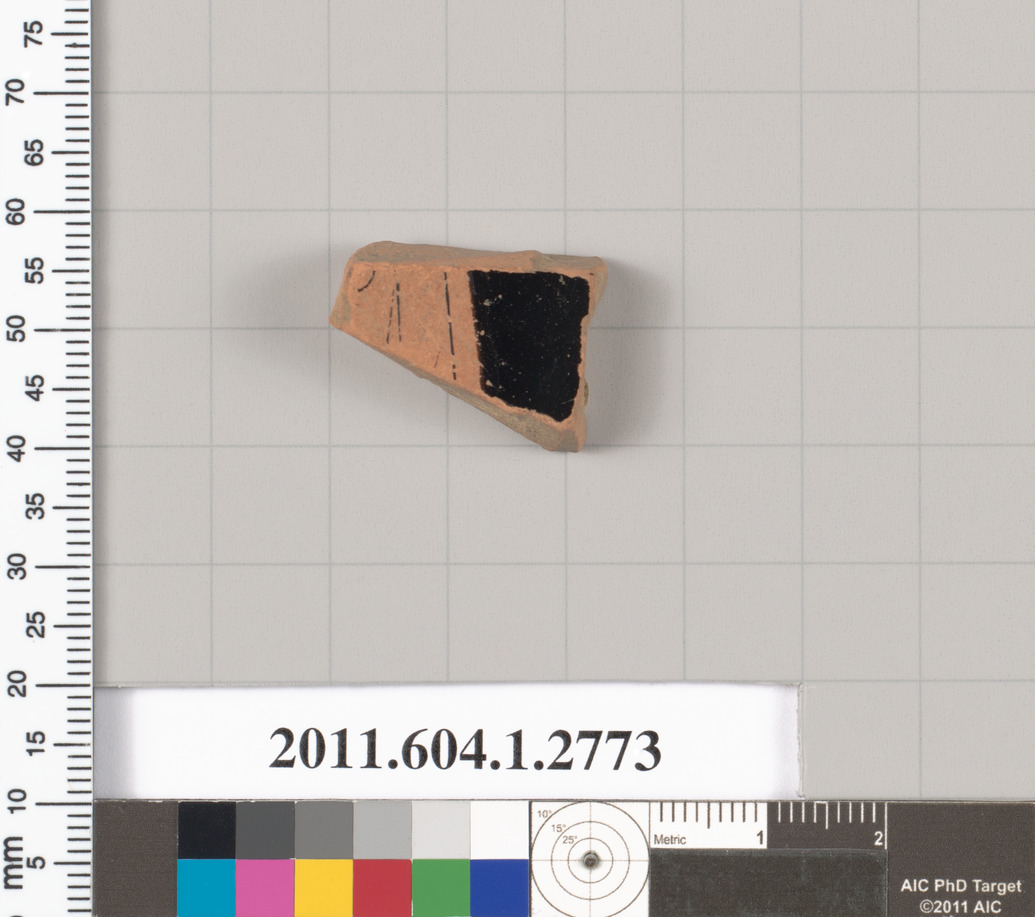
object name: kylix fragment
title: Terracotta fragment of a kylix (drinking cup)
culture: greek, attic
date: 475-451 BCE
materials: terracotta